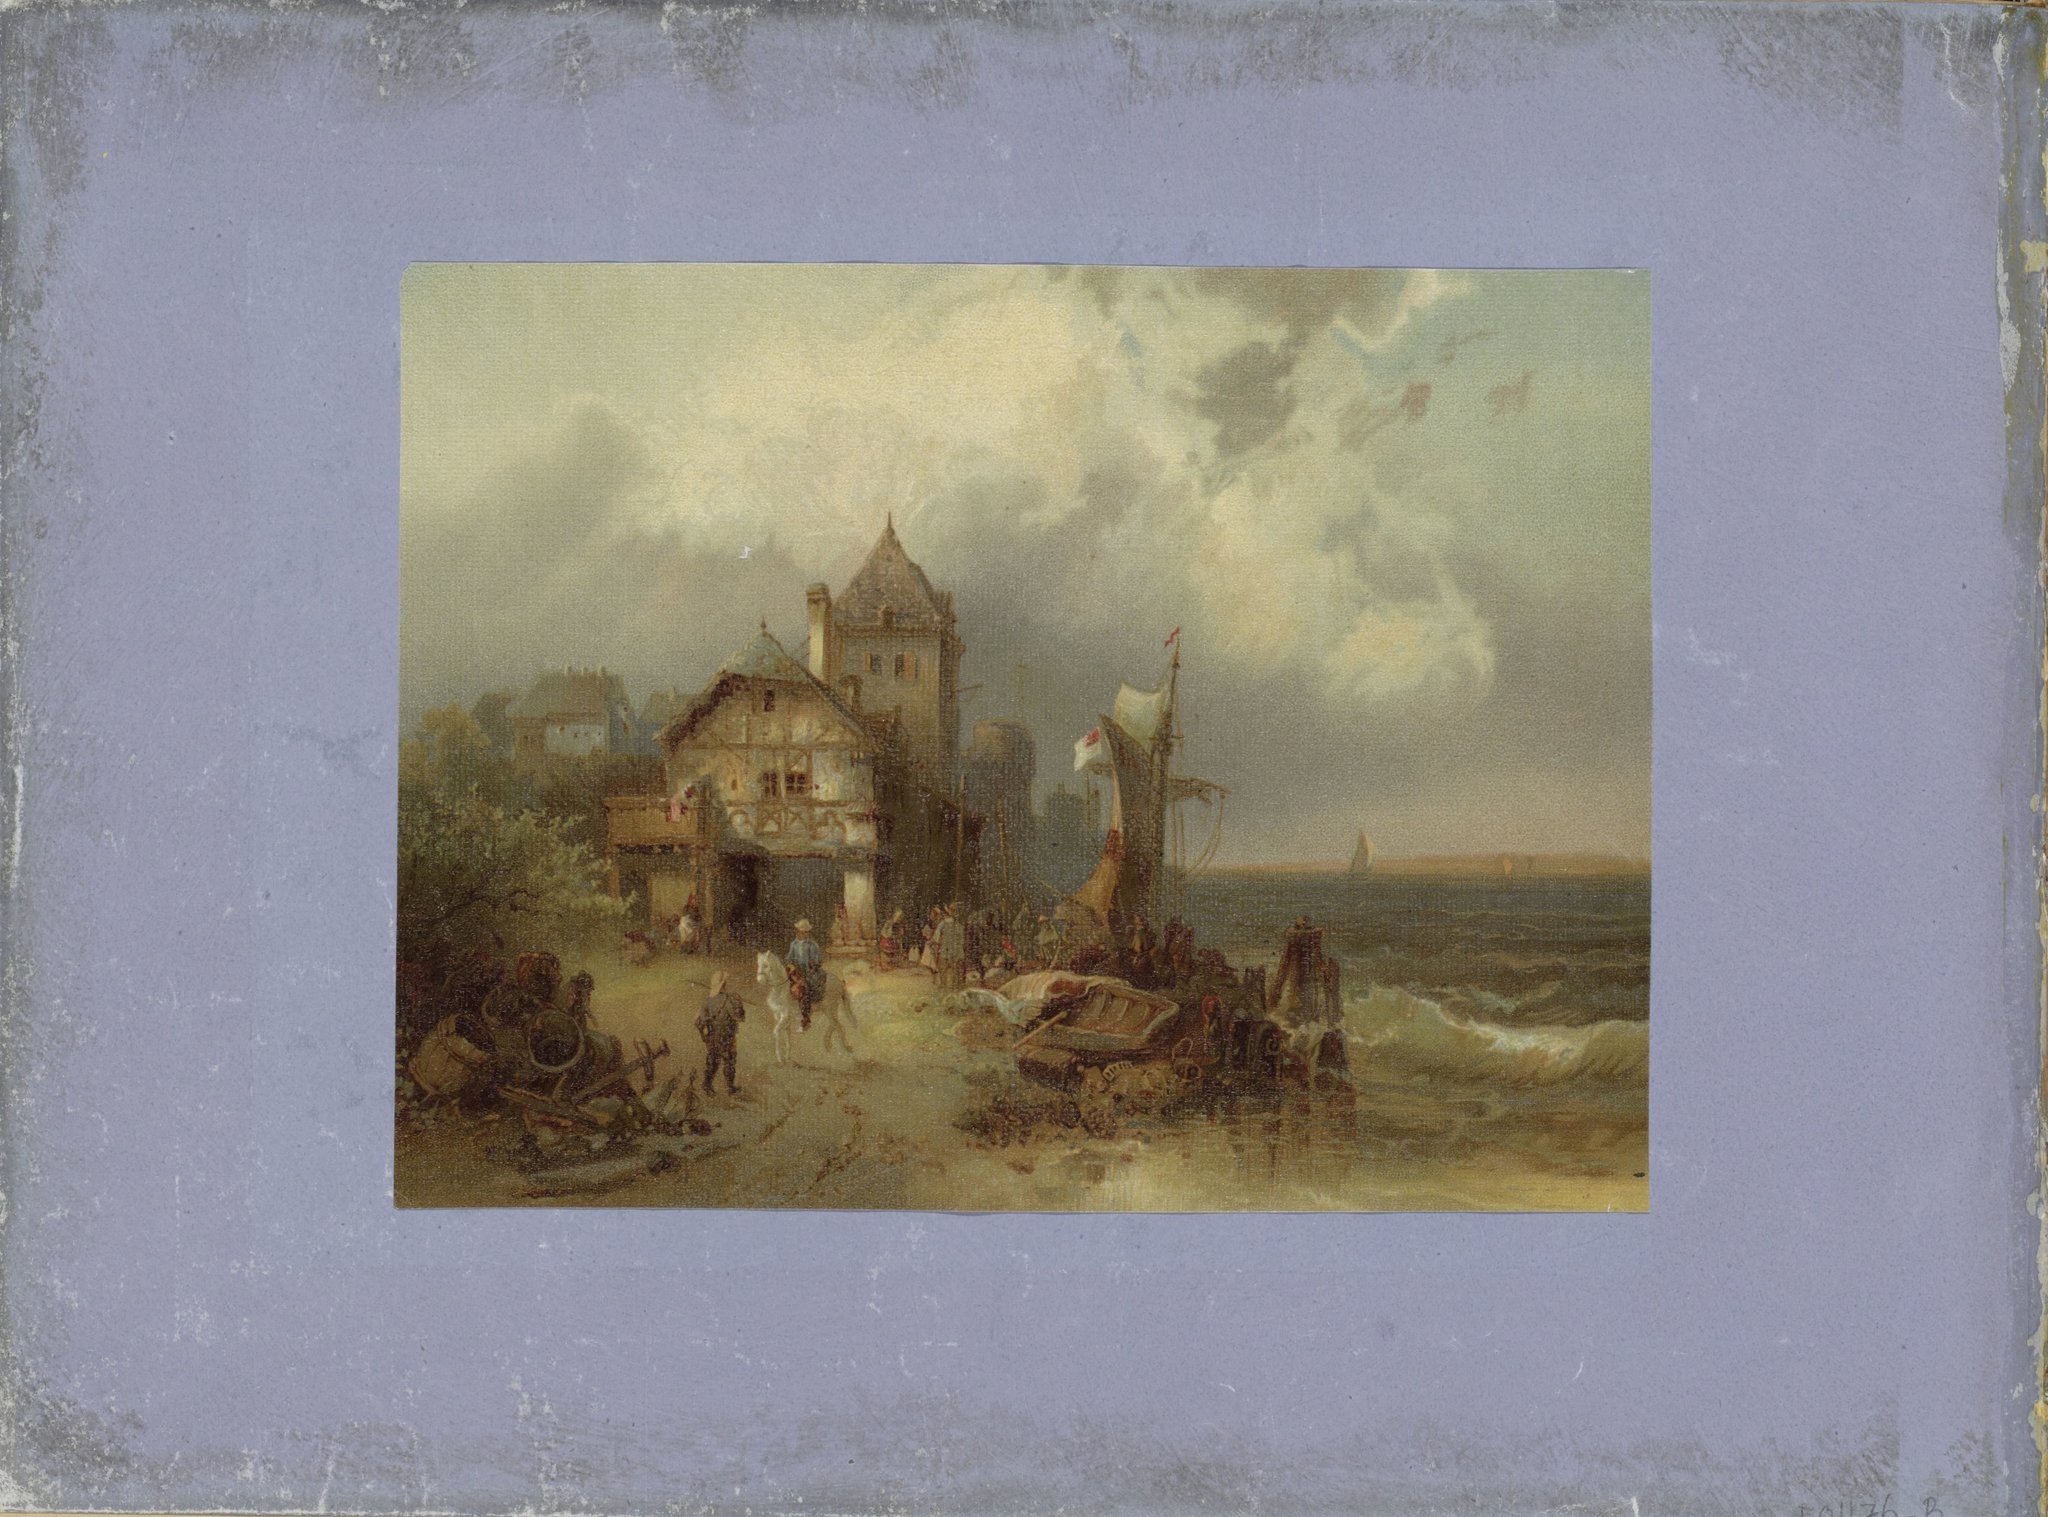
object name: print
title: Landschap bij zee naar een schilderij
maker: Anonymous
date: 1850-1876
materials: paper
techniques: chromolithography, oleograph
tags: landscapes with waters, waterscapes, seascapes (in the temperate zone), travelling; tourism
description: Onderdeel van Reisalbum met foto's en tekeningen van Manuel Mayo 1876.